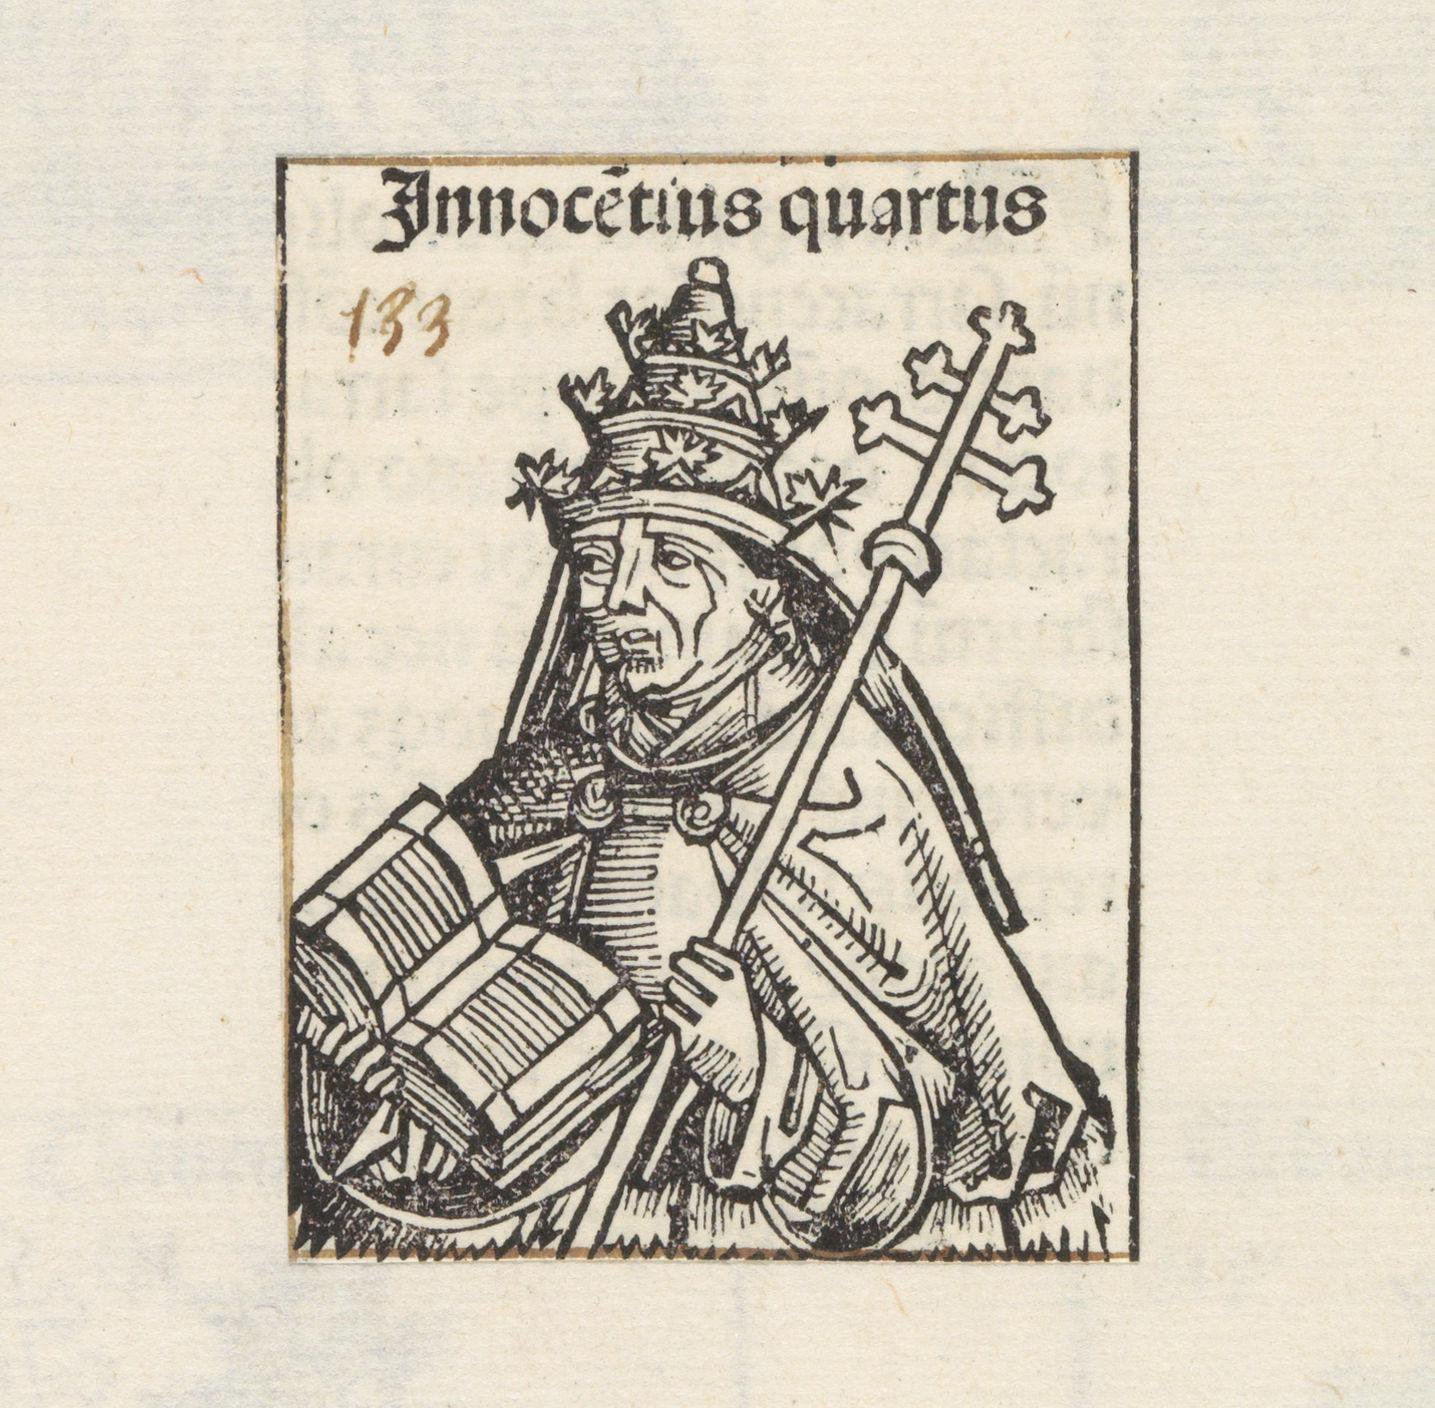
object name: book illustration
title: Innoce[n]tius quartus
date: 1493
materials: paper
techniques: letterpress printing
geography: nuremberg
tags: pope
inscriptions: inscription: ‘133’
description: Een bloemkelk met een paus. Hij draagt een tiara en heeft een opengeslagen boek en een staf met dubbel kruis in zijn handen. De voorstelling is onderdeel van de opeenvolging pausen in de Liber Chronicarum. De tekst identificeert de man als Innocentius IV. De prent maakt deel uit van een album.